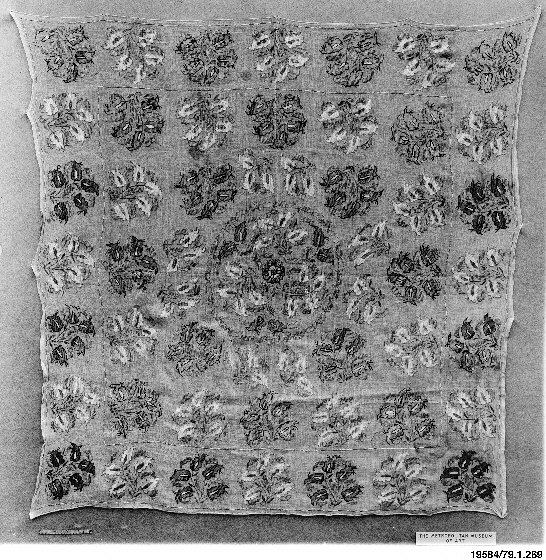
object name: cover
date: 1801-1833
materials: linen, metal thread, silk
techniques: embroidery, weave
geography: turkey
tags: flowers